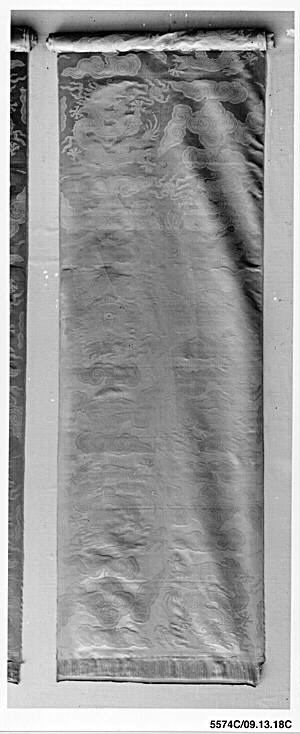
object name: piece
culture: chinese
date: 1801-1900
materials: silk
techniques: weave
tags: dragons